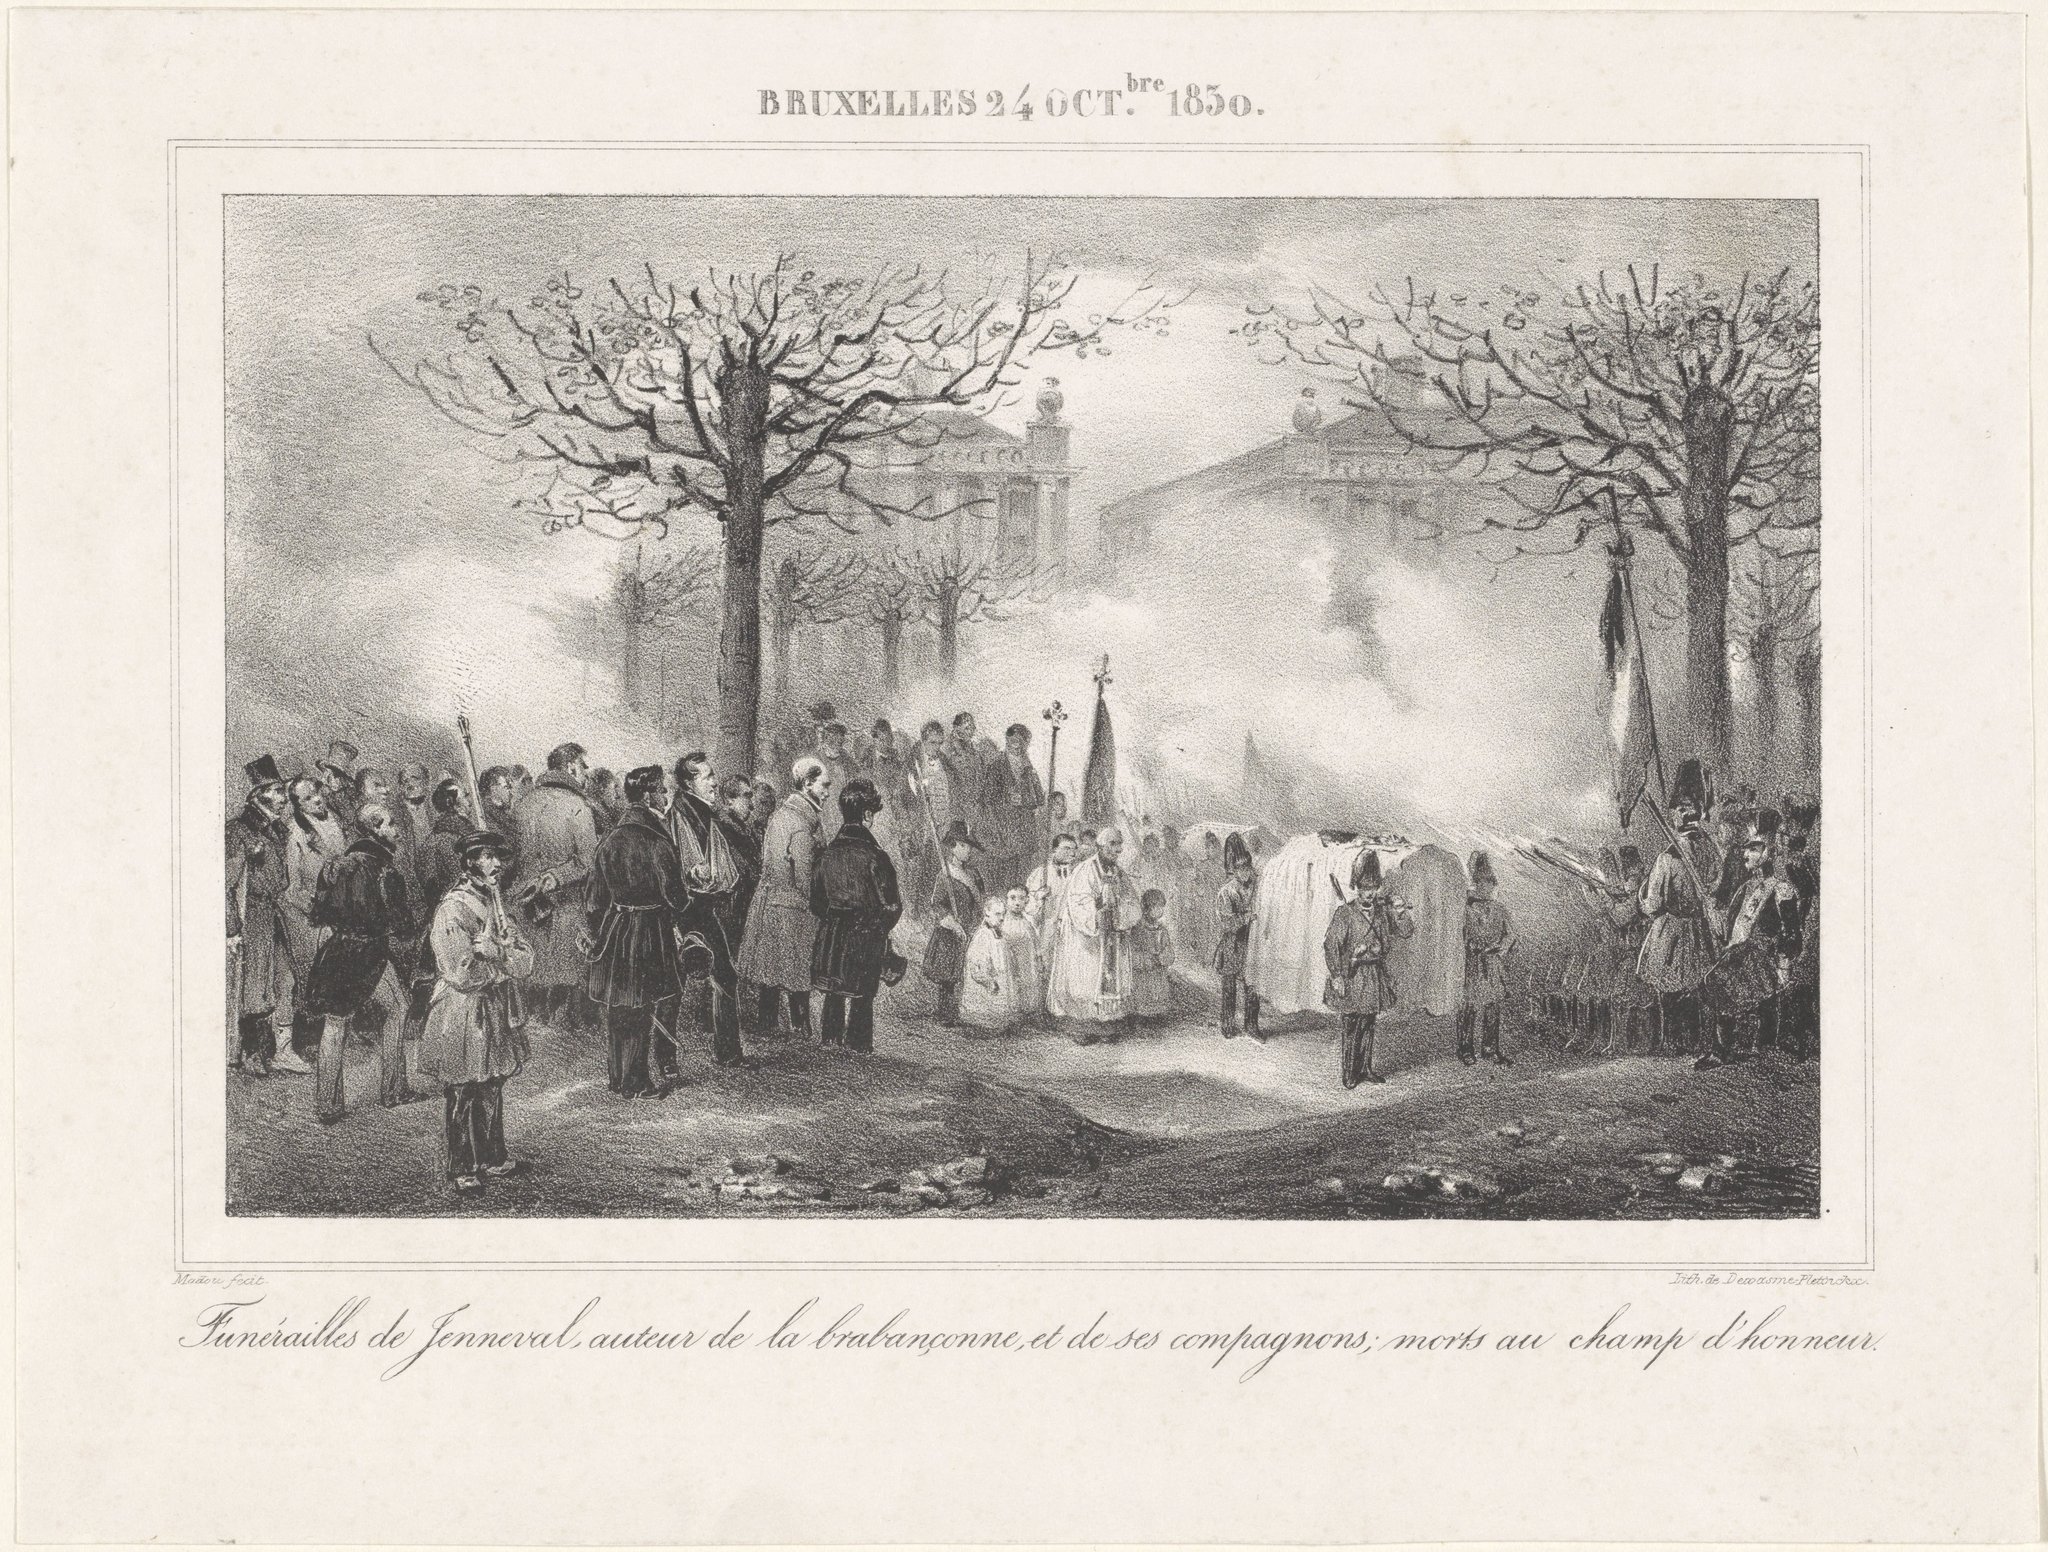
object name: print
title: Begrafenis van Jenneval, Brussel 1830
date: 1830-1831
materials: paper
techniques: lithograph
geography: brussels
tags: lyon, lierre, public funeral, brussels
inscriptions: collector's mark: Lugt 2228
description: Begrafenis van Alexandre Dechet, bijgenaamd Jenneval, auteur van de tekst het Belgische volkslied de Brabançonne, 24 oktober 1830 te Brussel. Onderdeel van een groep van prenten uit verschillende andere series verwant aan de platen in het recueil over de gebeurtenissen tijdens de Belgische Revolutie in Brussel, Antwerpen en andere steden in de periode 25 augustus 1830 tot 27 maart 1831.